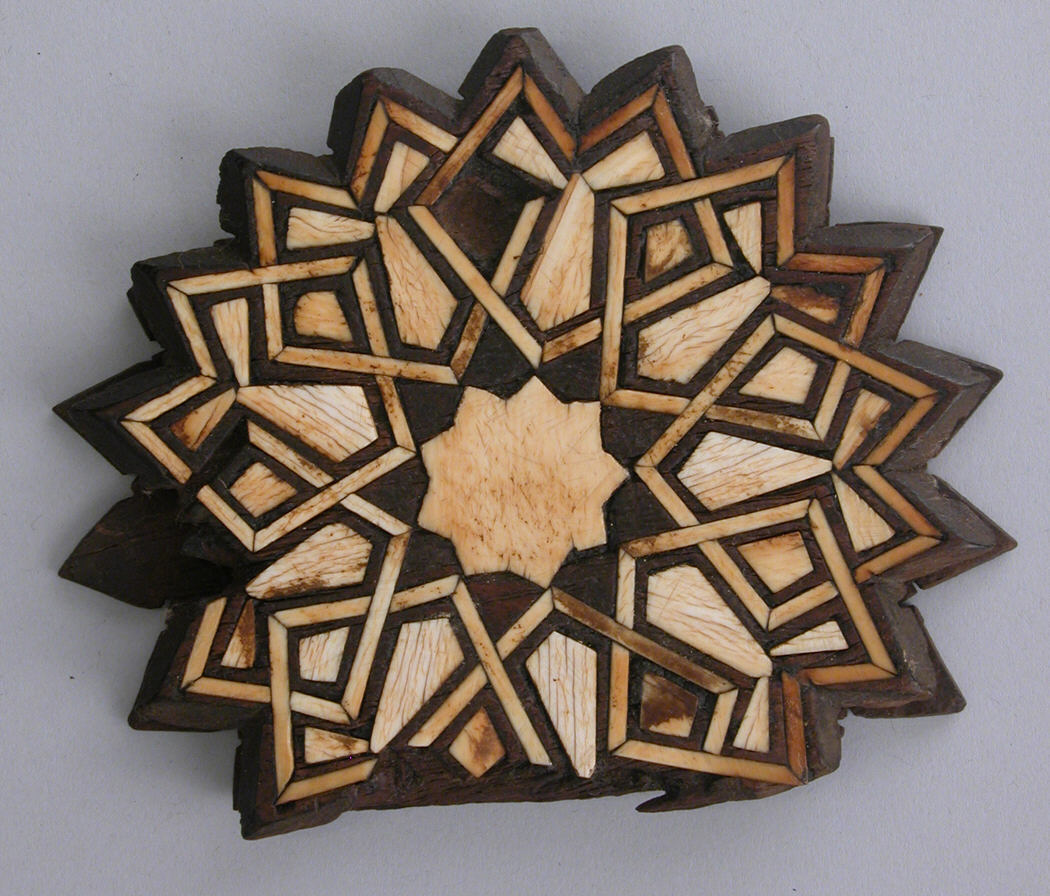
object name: panel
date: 1301-1500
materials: ivory, wood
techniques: carving, inlay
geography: egypt